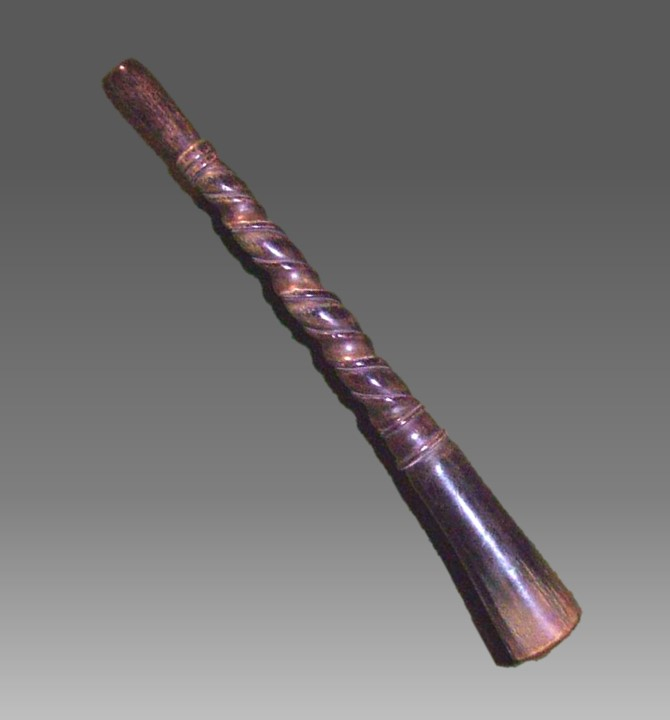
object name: falconer's horn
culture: german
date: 1701-1800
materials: horn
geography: germany